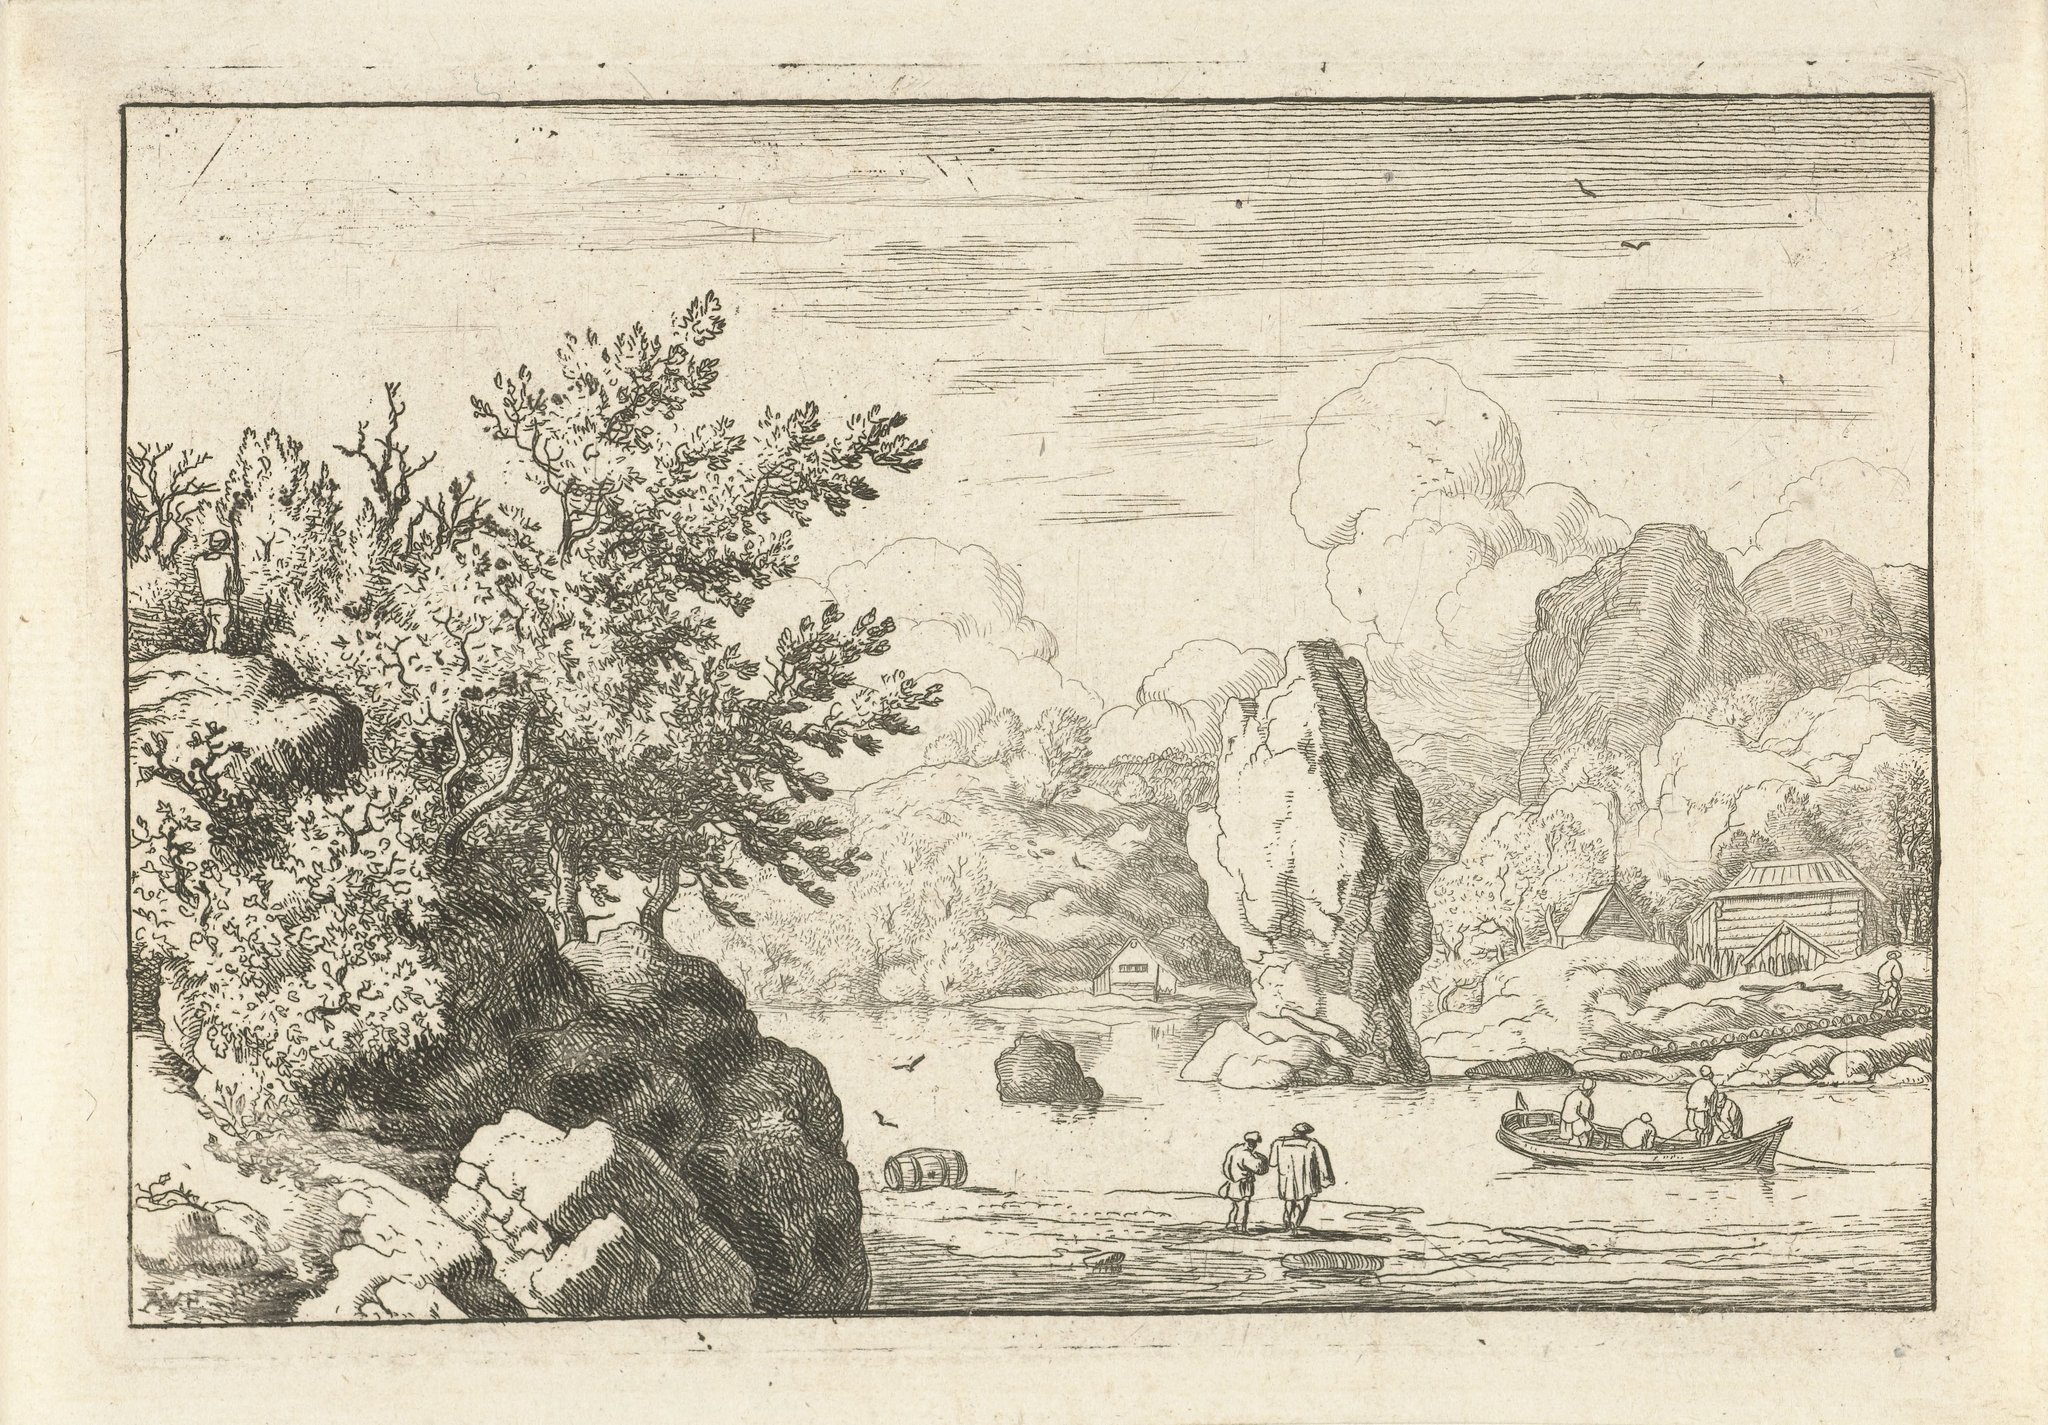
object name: print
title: Landschap met twee personen op het strand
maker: allaert van everdingen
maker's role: draughtsman, painter, print maker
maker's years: 1621-1675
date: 1631-1675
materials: paper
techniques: etching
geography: netherlands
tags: river (+ landscape with figures, staffage)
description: Berglandschap met op de voorgrond een man op een hoge rotspartij. Op het water een roeiboot met vier personen en langs de kant twee toeschouwers.